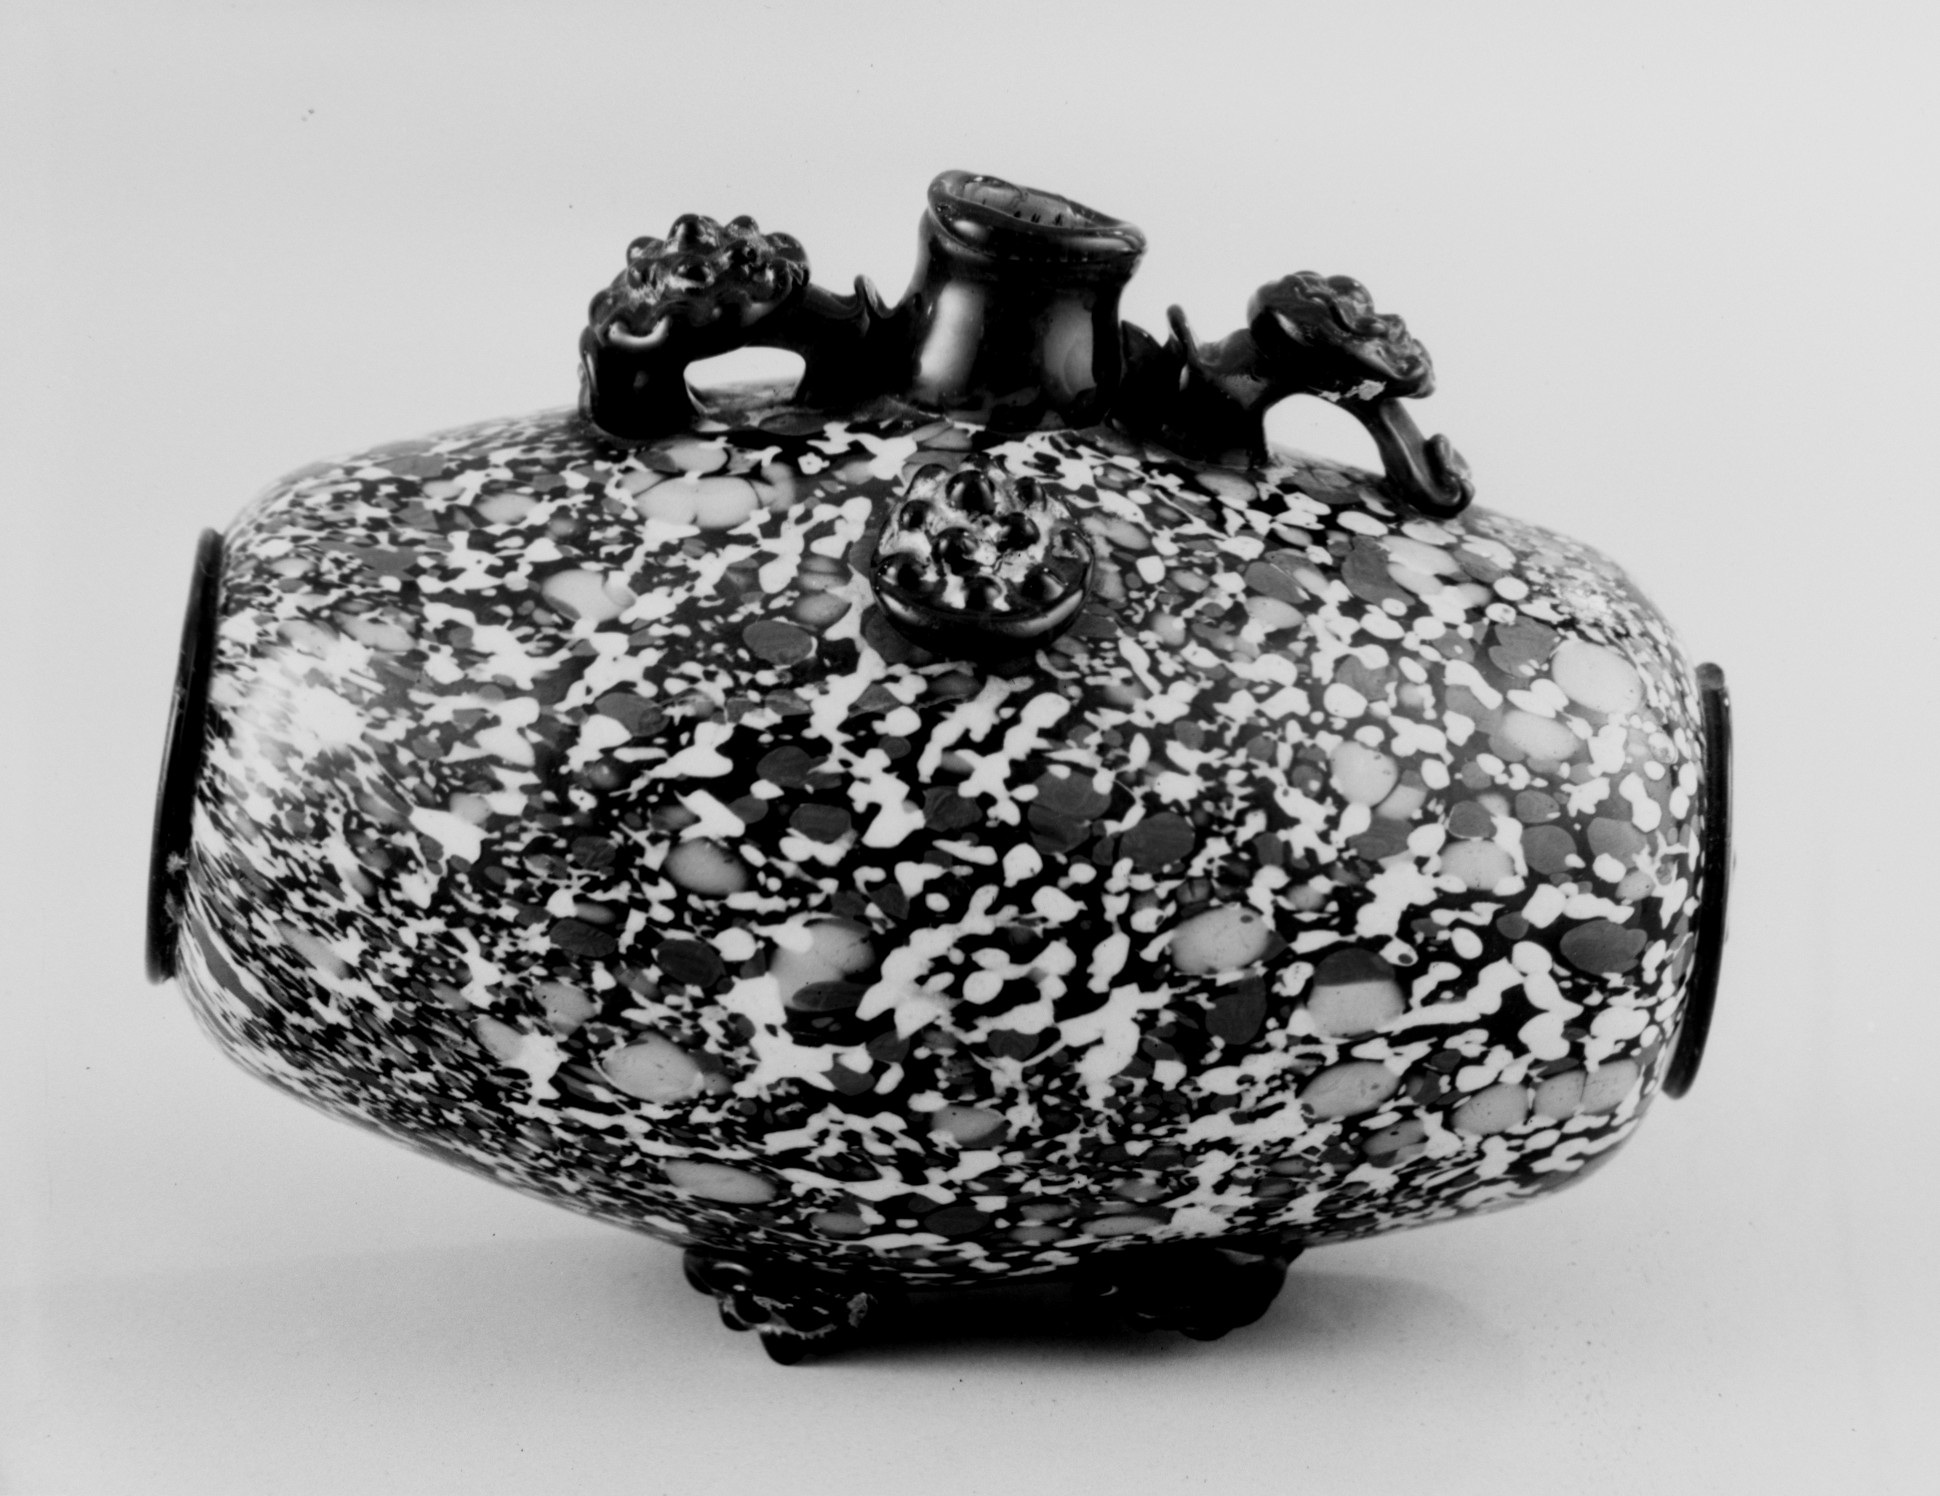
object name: flask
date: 1601-1700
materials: glass